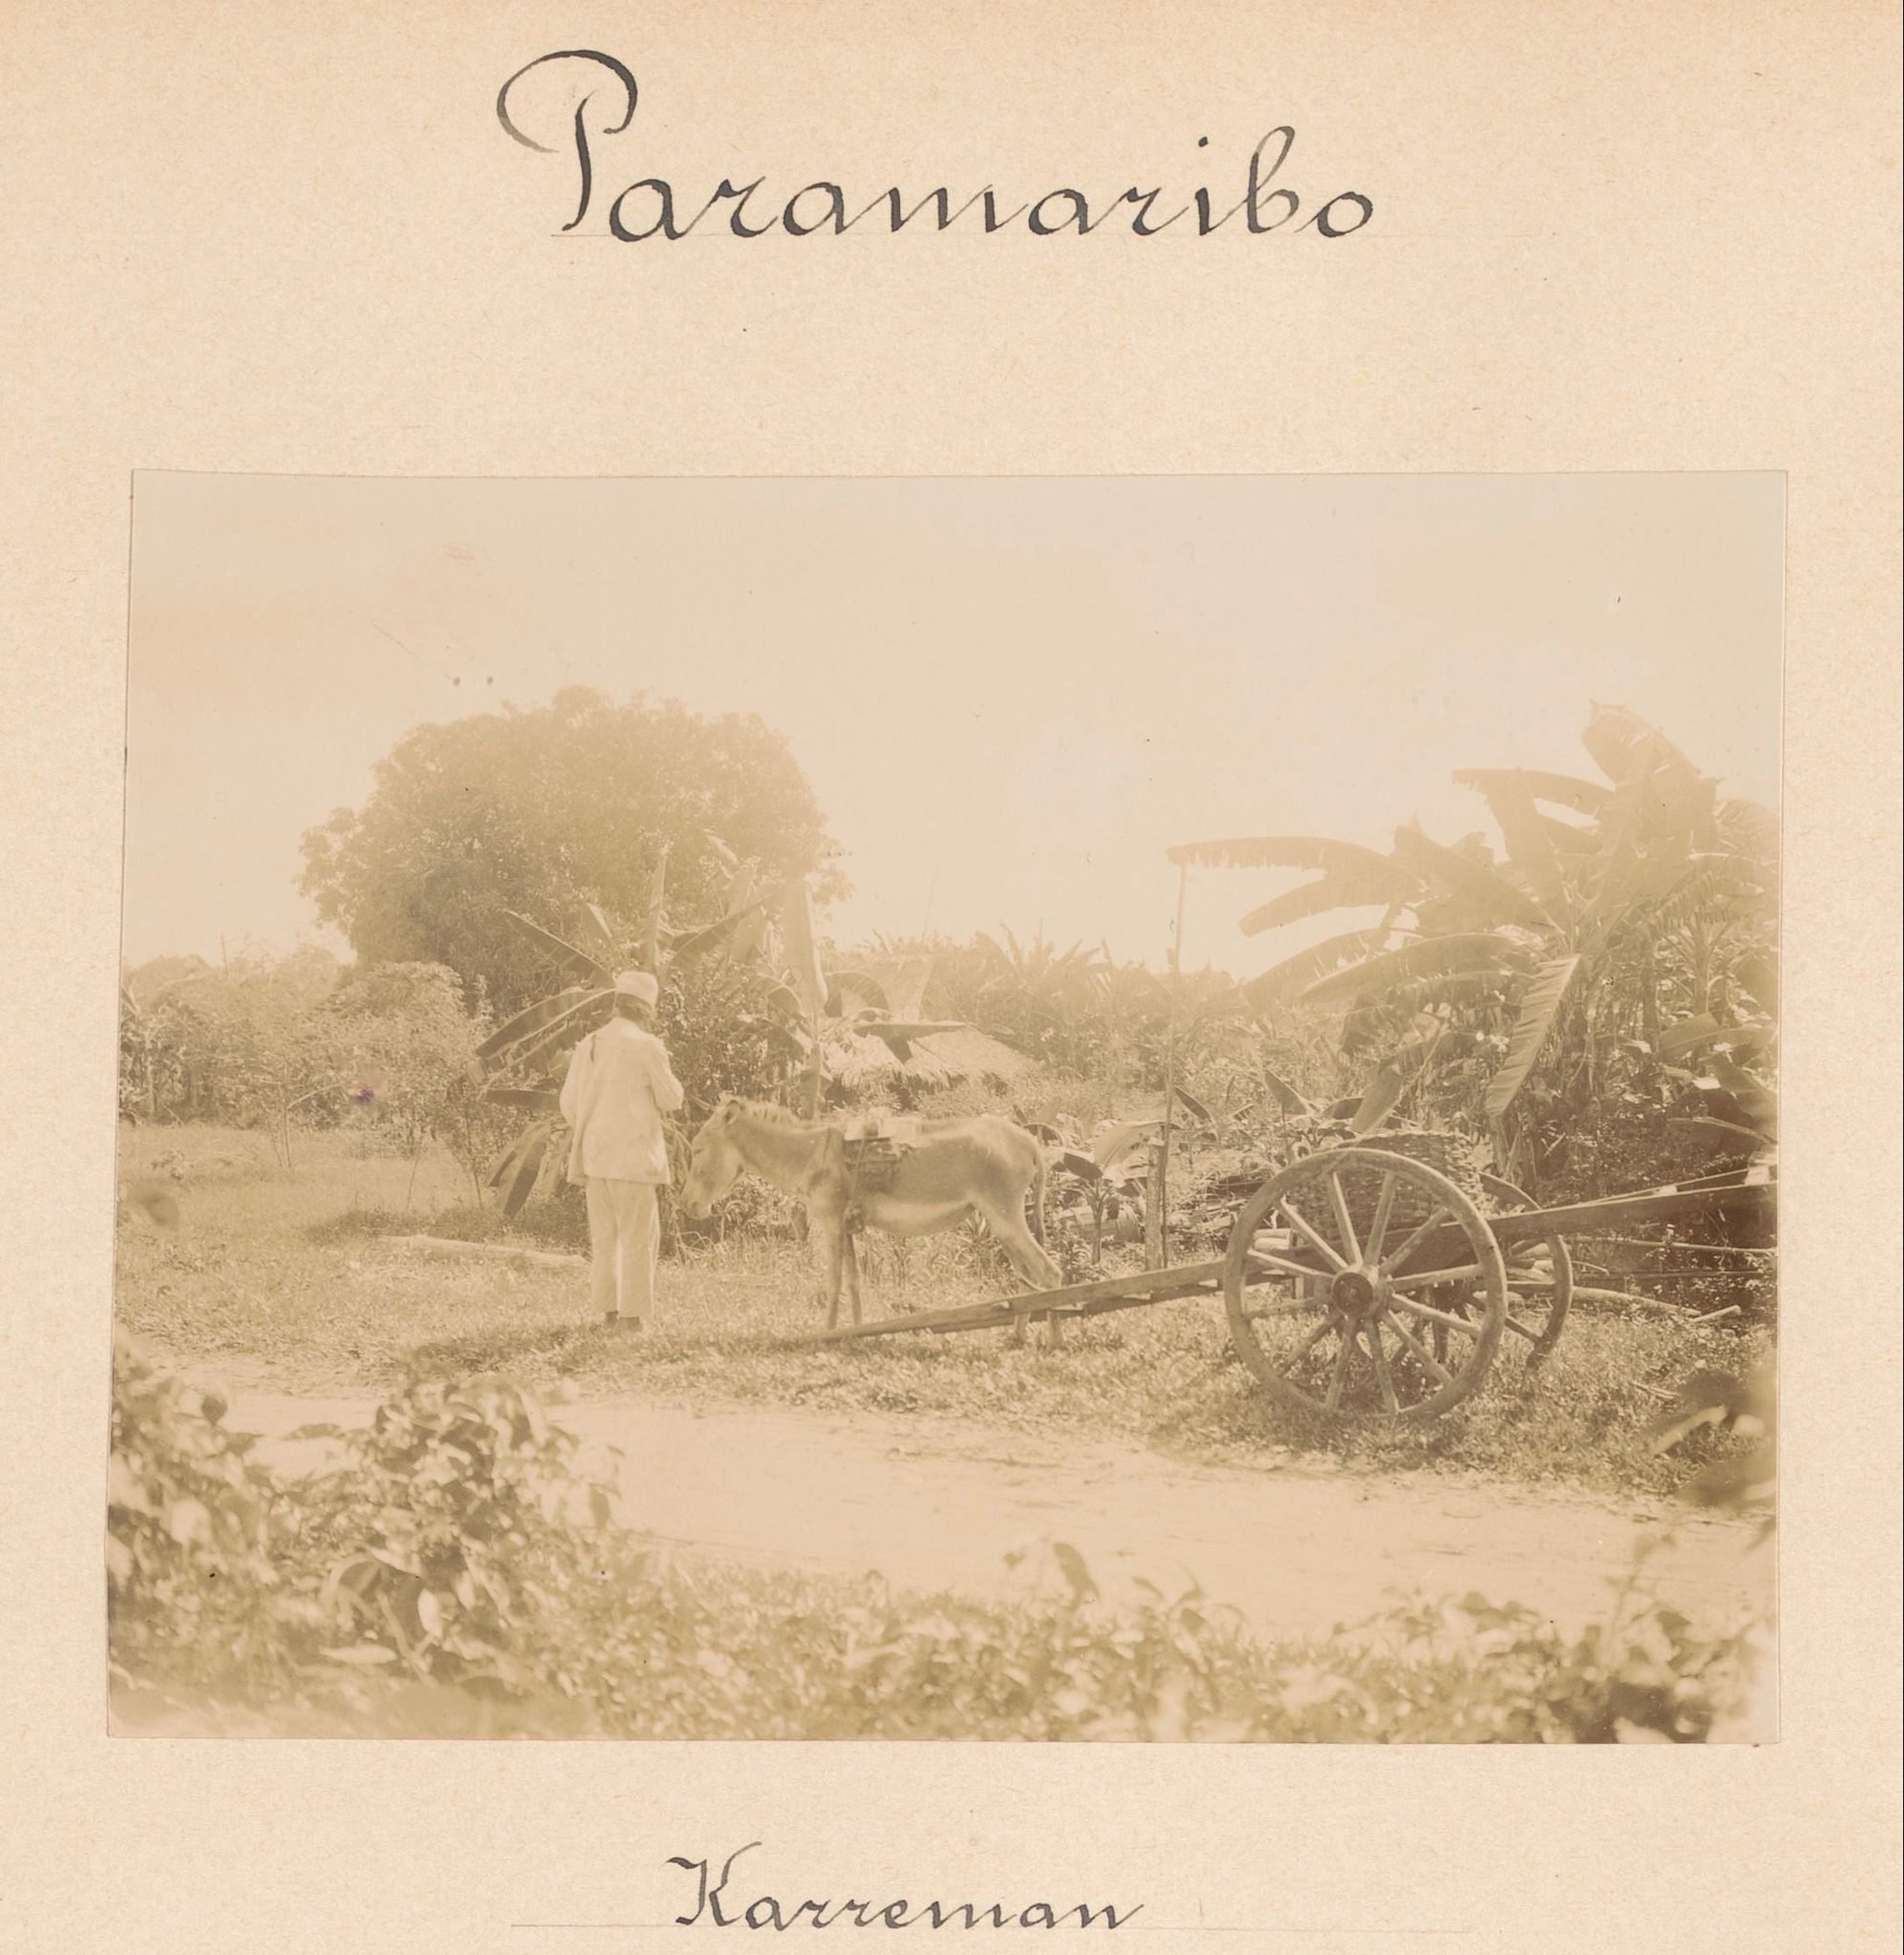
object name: photograph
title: Karreman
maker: eugen klein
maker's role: fotograaf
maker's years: 1869-1927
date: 1900-1905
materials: cardboard, photographic support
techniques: gelatin silver print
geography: paramaribo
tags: paramaribo (stad)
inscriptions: inscription: ‘Paramaribo / Karreman’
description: Een man met een kar en een ezel, staande langs een weg te Paramaribo. Onderdeel van een groep van 44 foto's van Paramaribo, Suriname en Curaçao, ca. 1900-1905, opgeplakt op kartons en voorzien van opschriften.